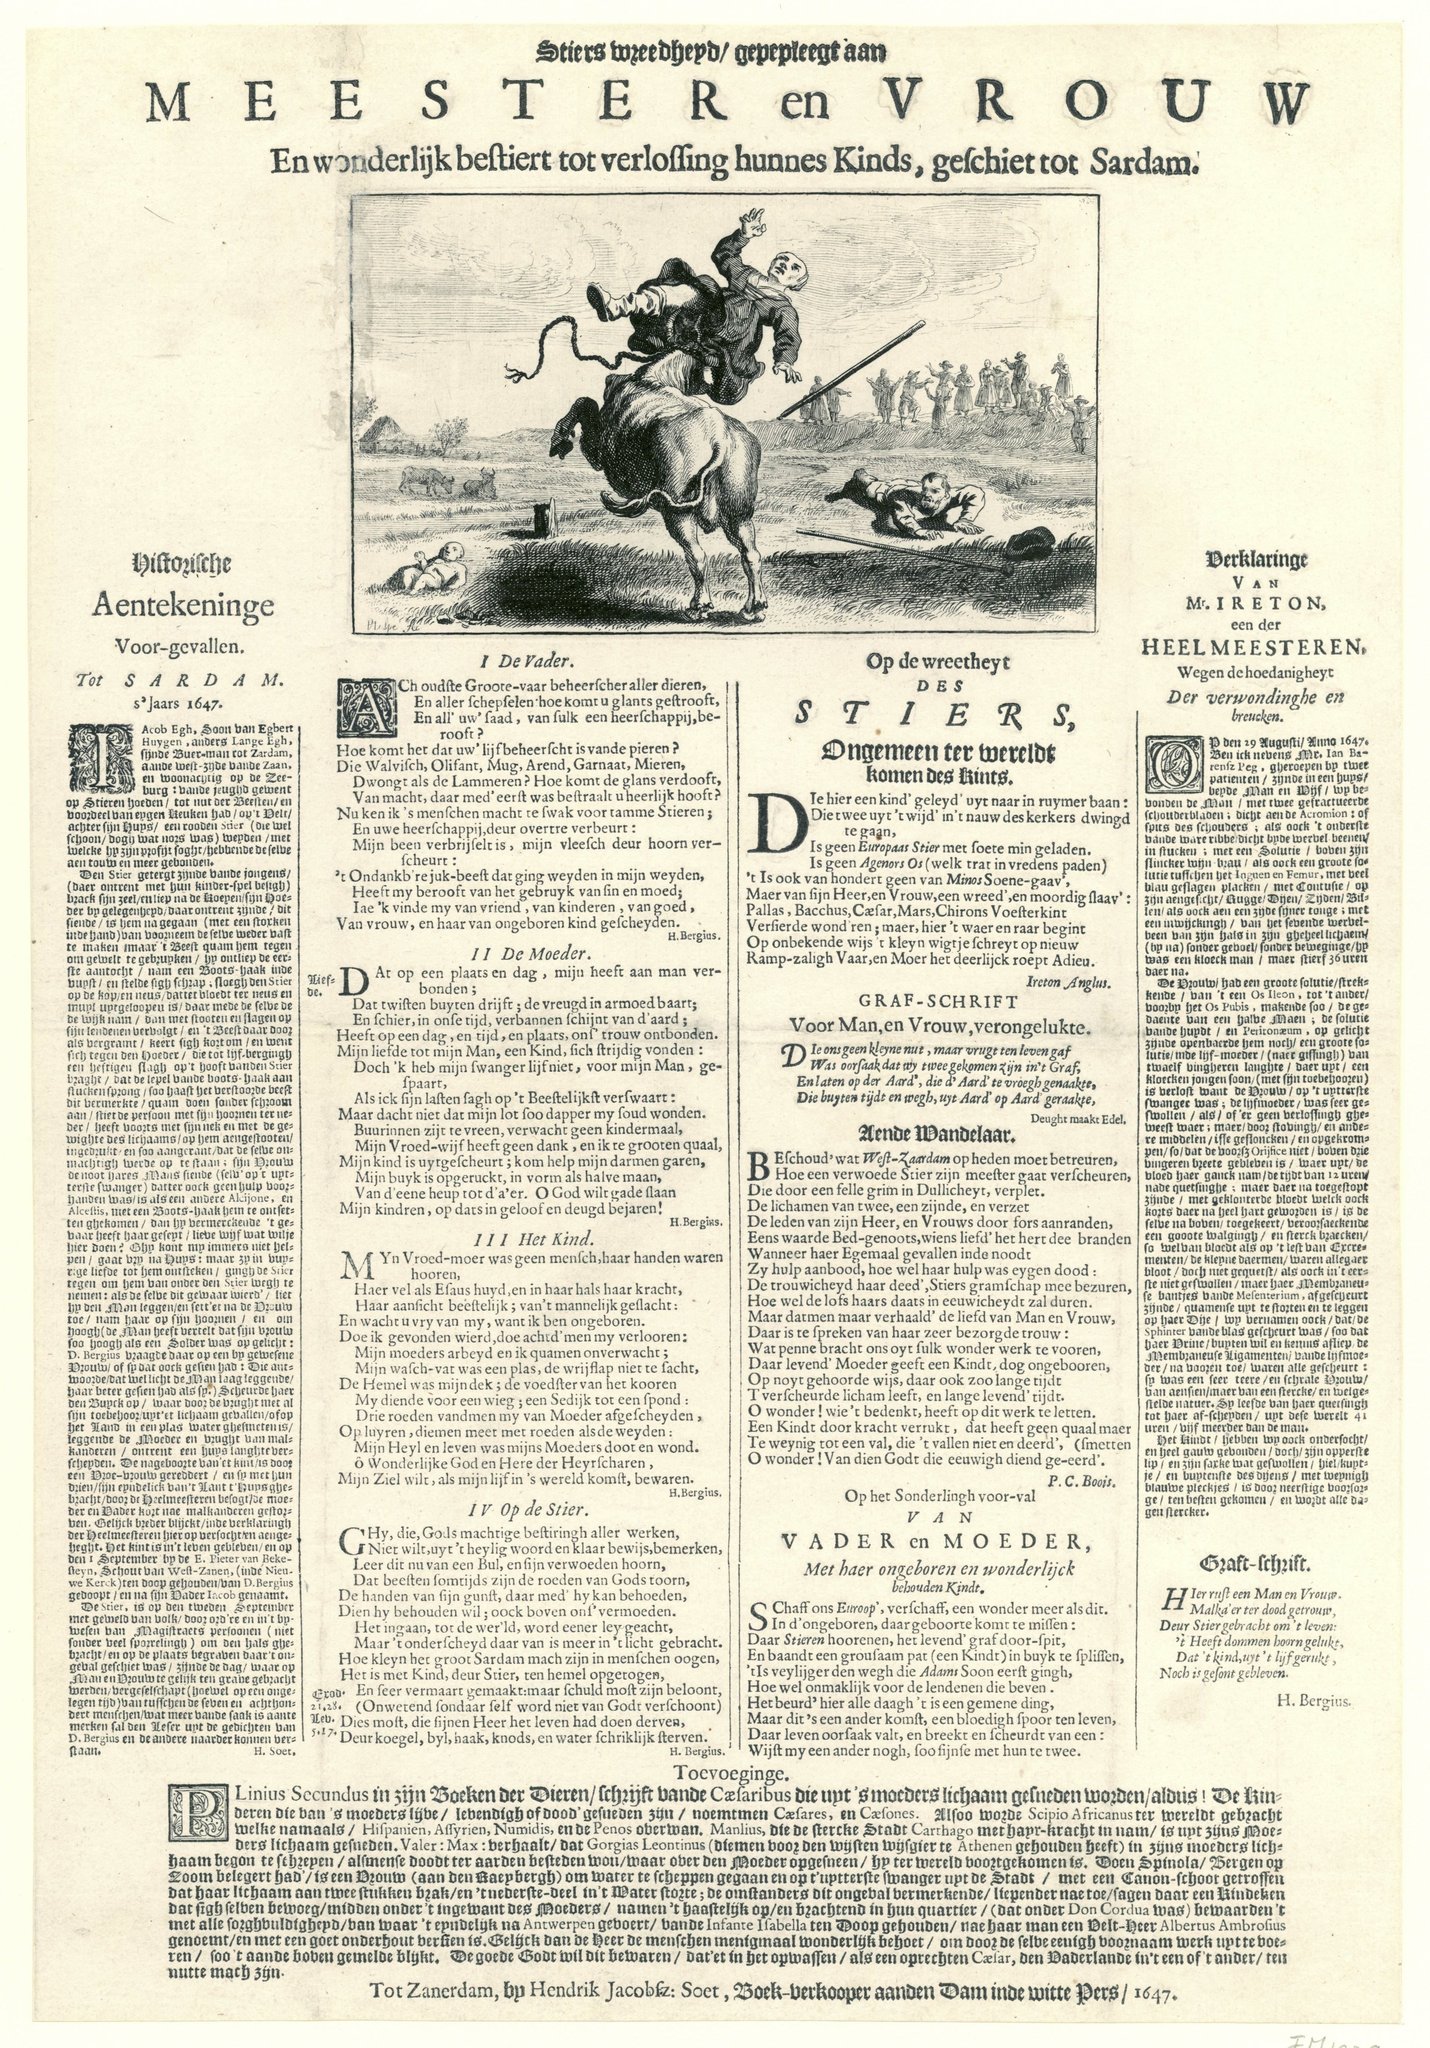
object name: print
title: De wreedheid van de stier, 1647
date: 1647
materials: paper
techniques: engraving, etching, letterpress printing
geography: northern netherlands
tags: bull, difficult and unusual birth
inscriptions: date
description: Illustratie van de gebeurtenissen die bekend staan als de wreedheid van de stier, 1647. De boer en zijn zwangere echtgenote die op 29 augustus 1647 te Zaandam door een stier werden aangevallen. Deze kleine prent toont hoe de vrouw op de horens wordt genomen waarbij het kind uit de buik wordt geslingerd. Onder de voorstelling in vier kolommen een beschrijving van de gebeurtenissen, verschillende verzen over de hoofdrolspelers en een verklaring van Mr. Ireton, een van de betrokken artsen.